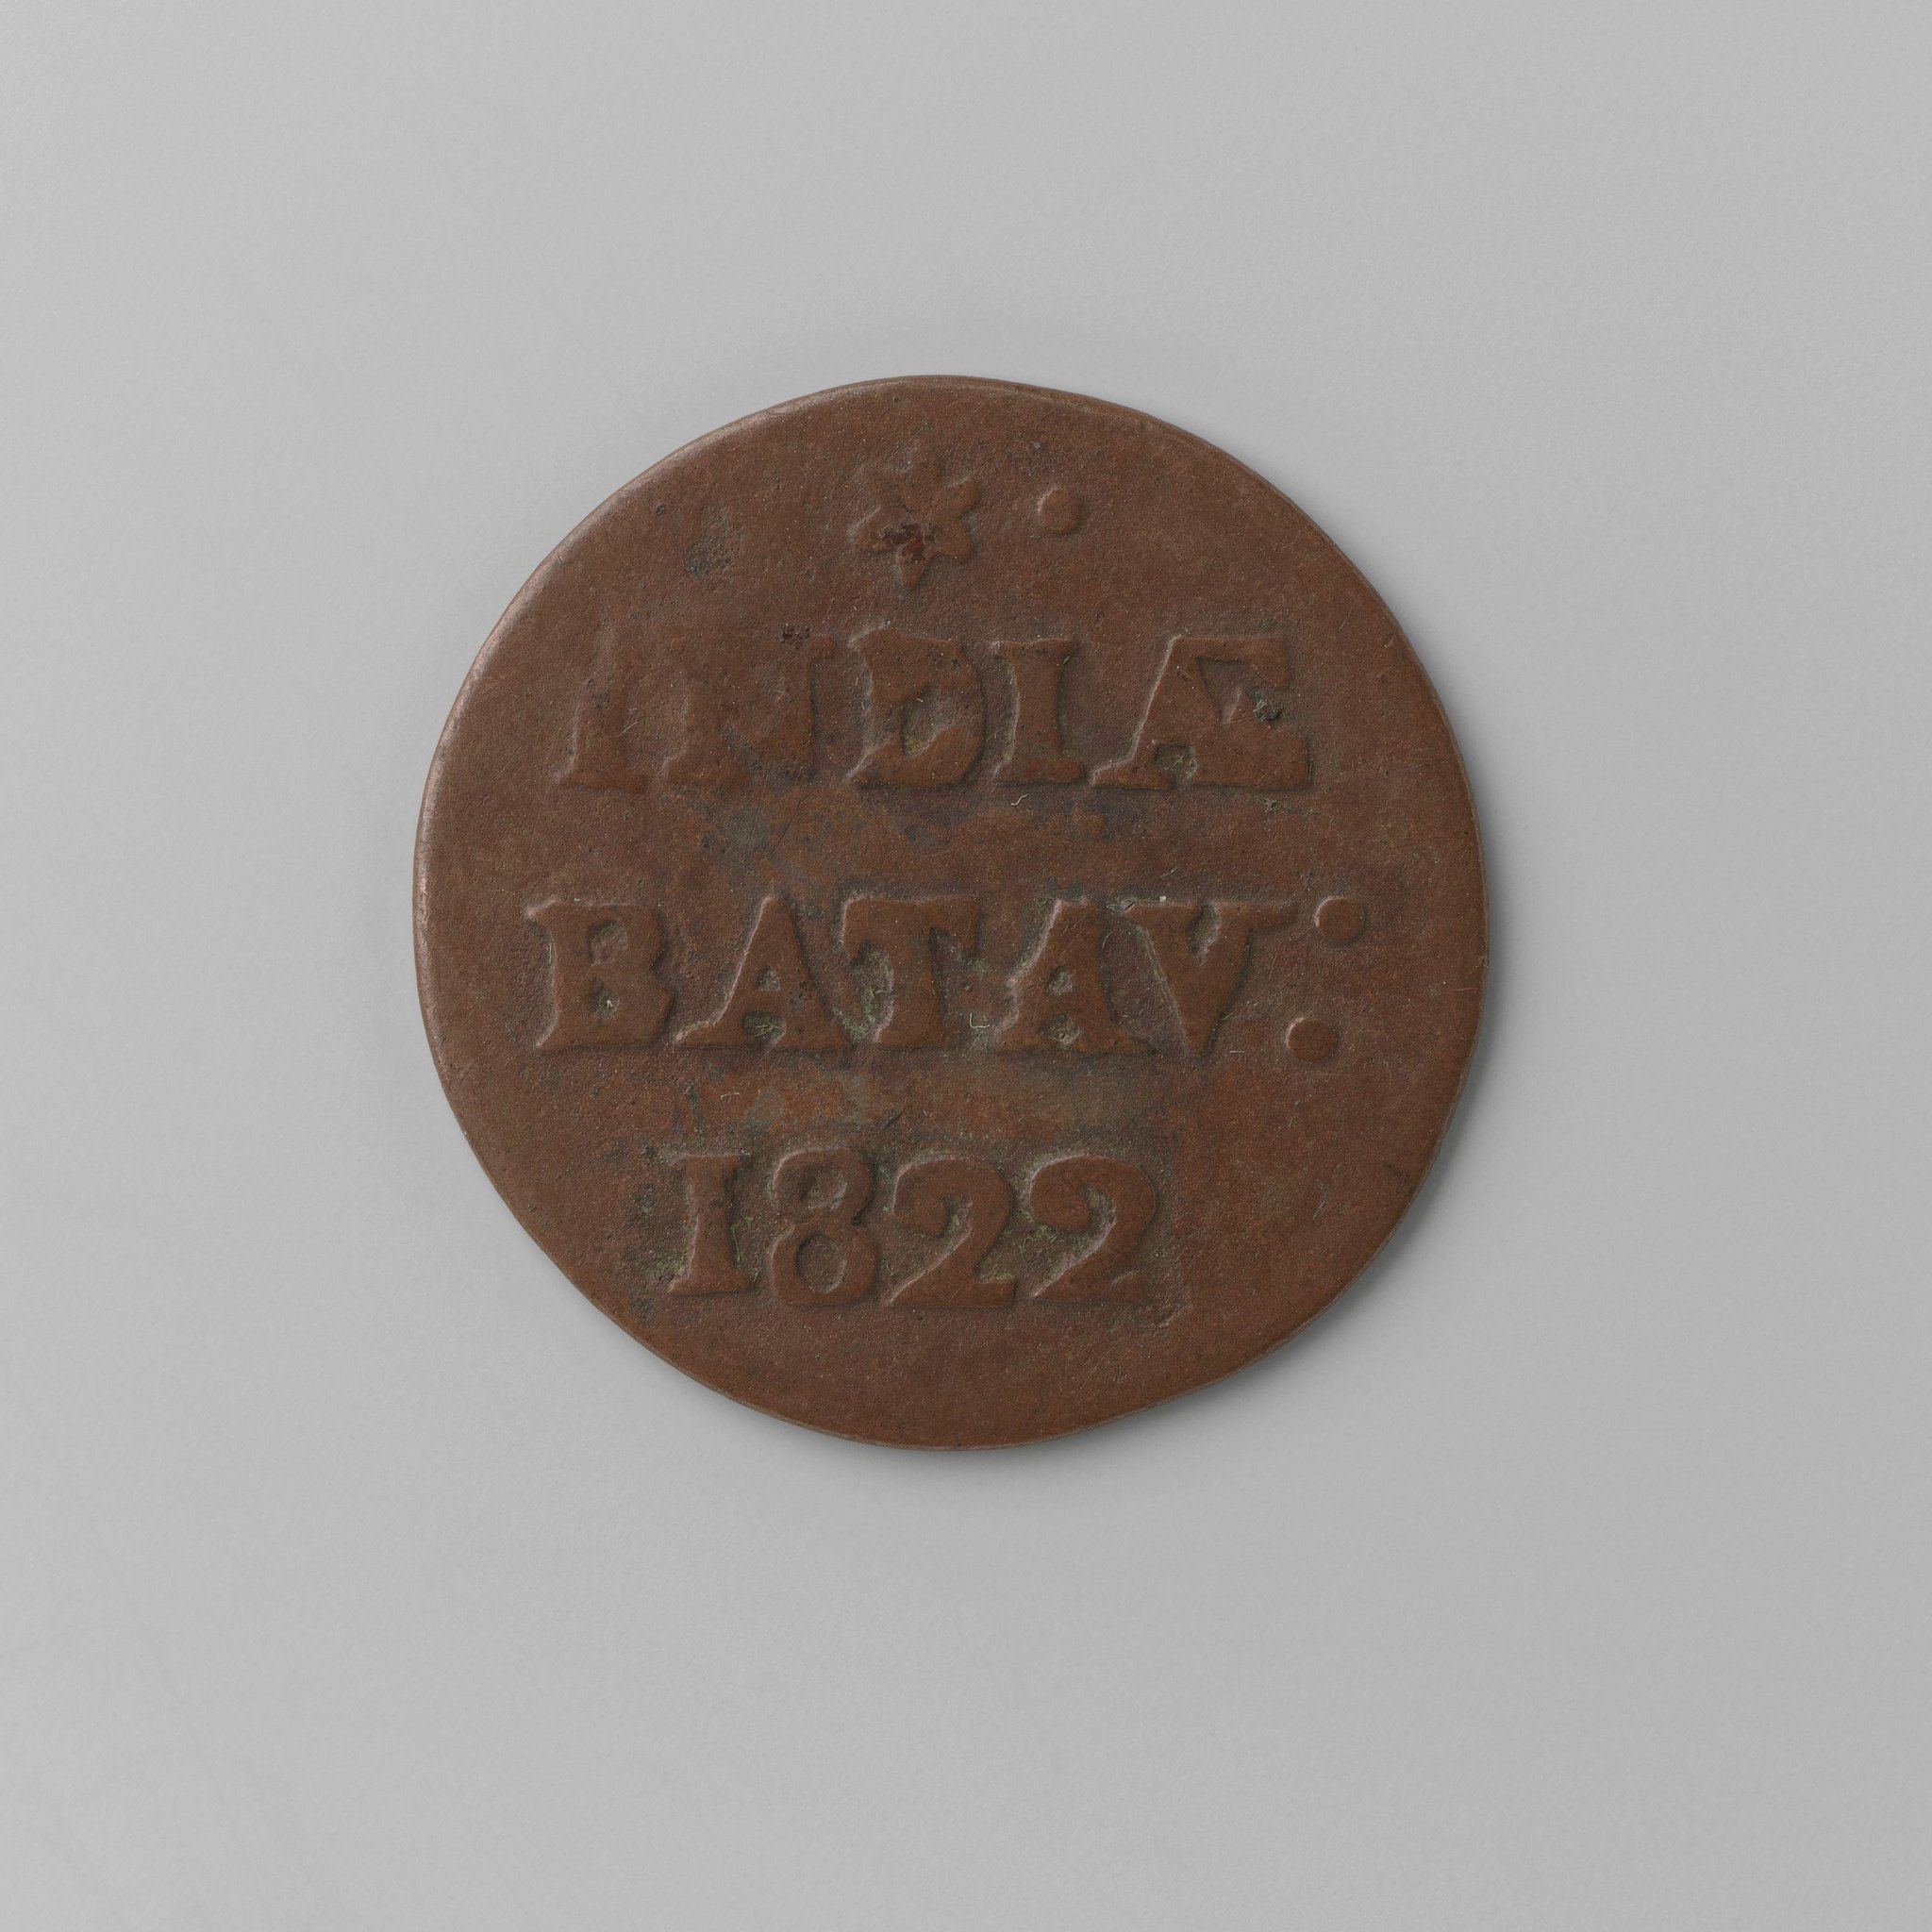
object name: coin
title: Nederlands Indië, ½ duit, 1822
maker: william i of the netherlands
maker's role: koning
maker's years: 1772-1843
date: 1822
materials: copper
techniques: striking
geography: surabaya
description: Koperen munt. Voorzijde: tussen waarde-aanduiding 5 1/32 G. gekroond generaliteitswapenschild. Keerzijde: tweeregelig opschrift, waarboven muntteken en waaronder jaartal. Gladde rand.